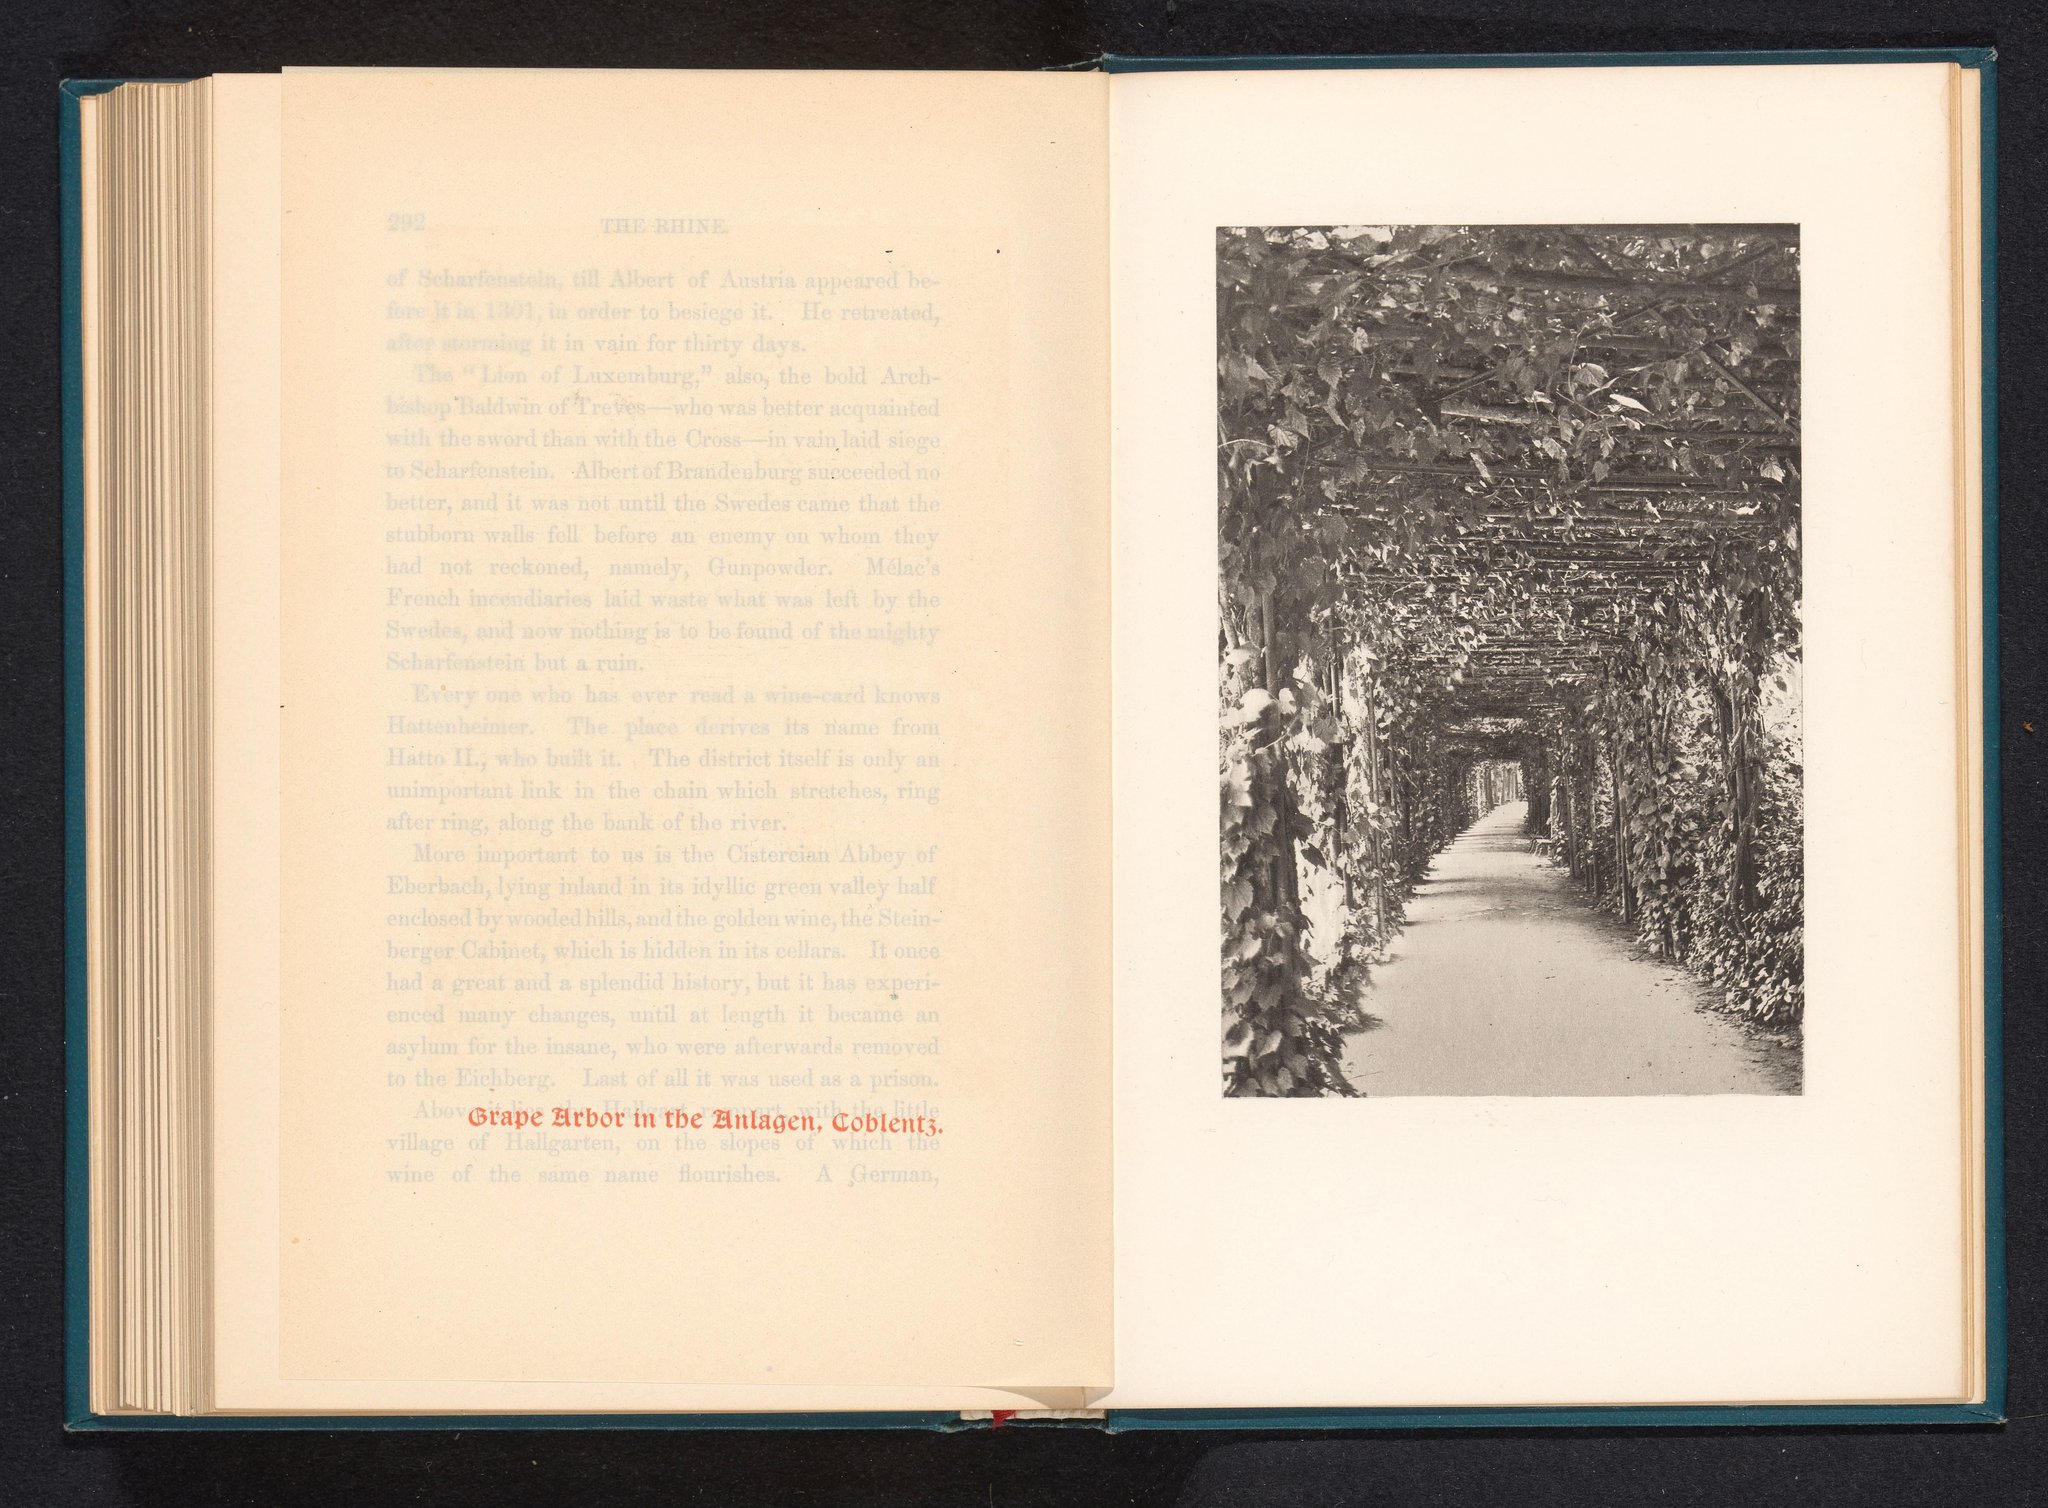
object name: page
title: Weg met druivenranken in de Rheinanlagen te Koblenz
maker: Anonymous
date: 1889-1899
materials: paper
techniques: photoaquatint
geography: koblenz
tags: vine, public road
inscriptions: title: ‘Grape Arbor in the Anlagen, Coblentz.’